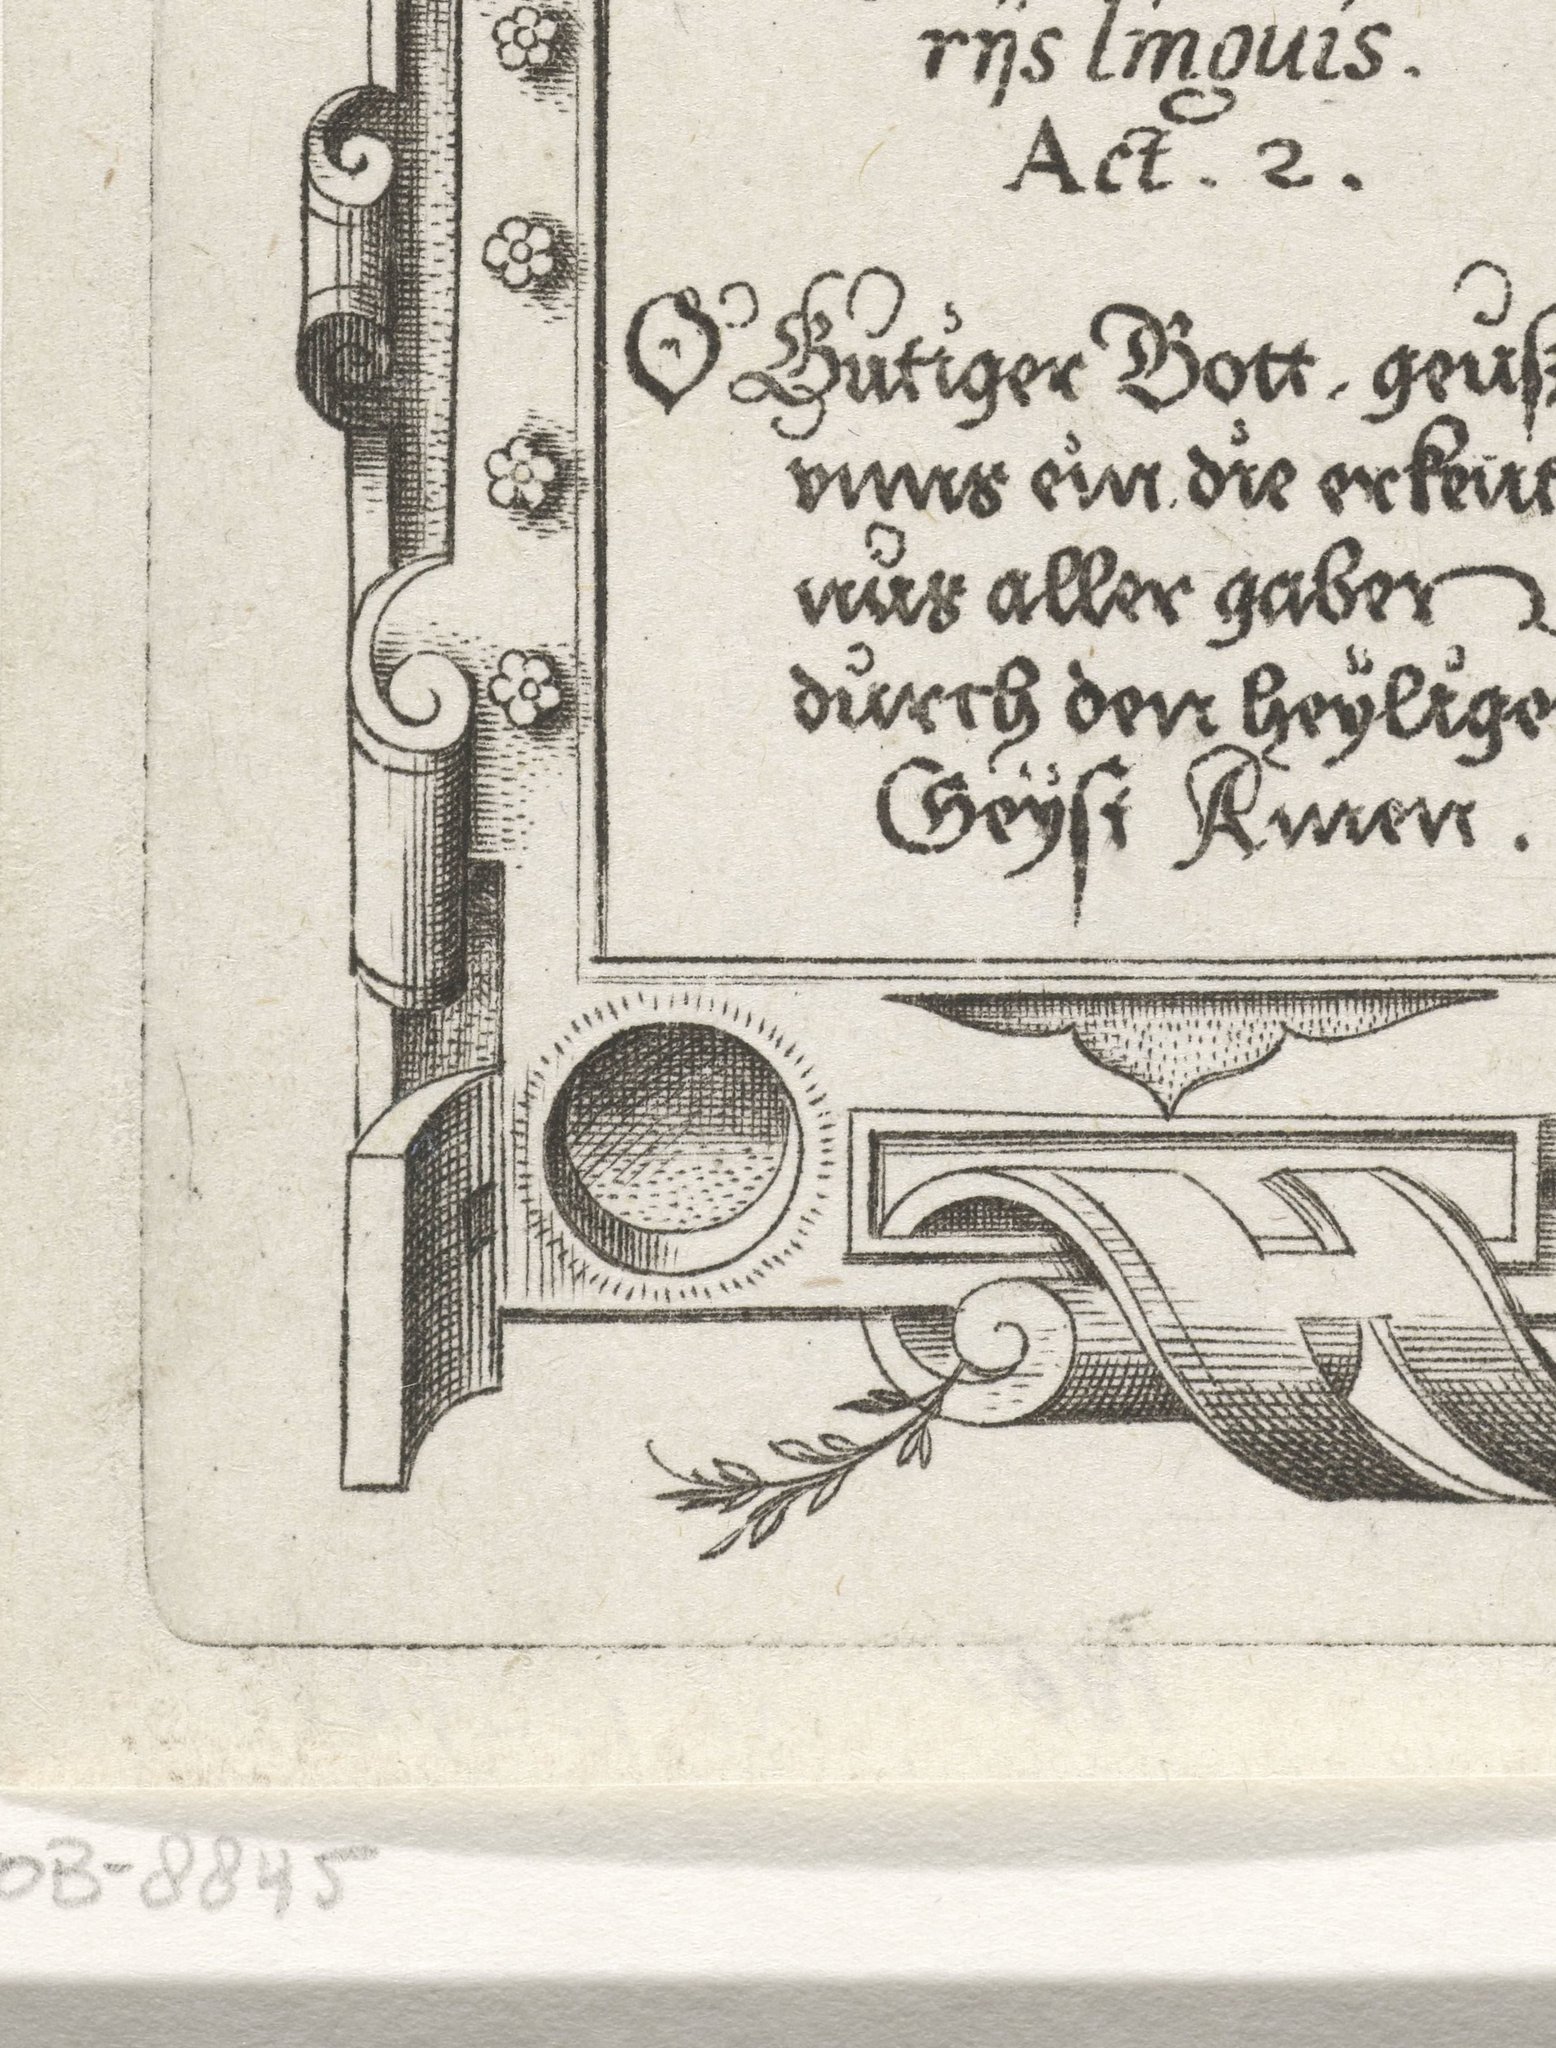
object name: print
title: Tekst: Et repleti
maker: virgilius solis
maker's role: draughtsman, print maker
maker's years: 1514-1562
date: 1524-1562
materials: paper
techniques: engraving